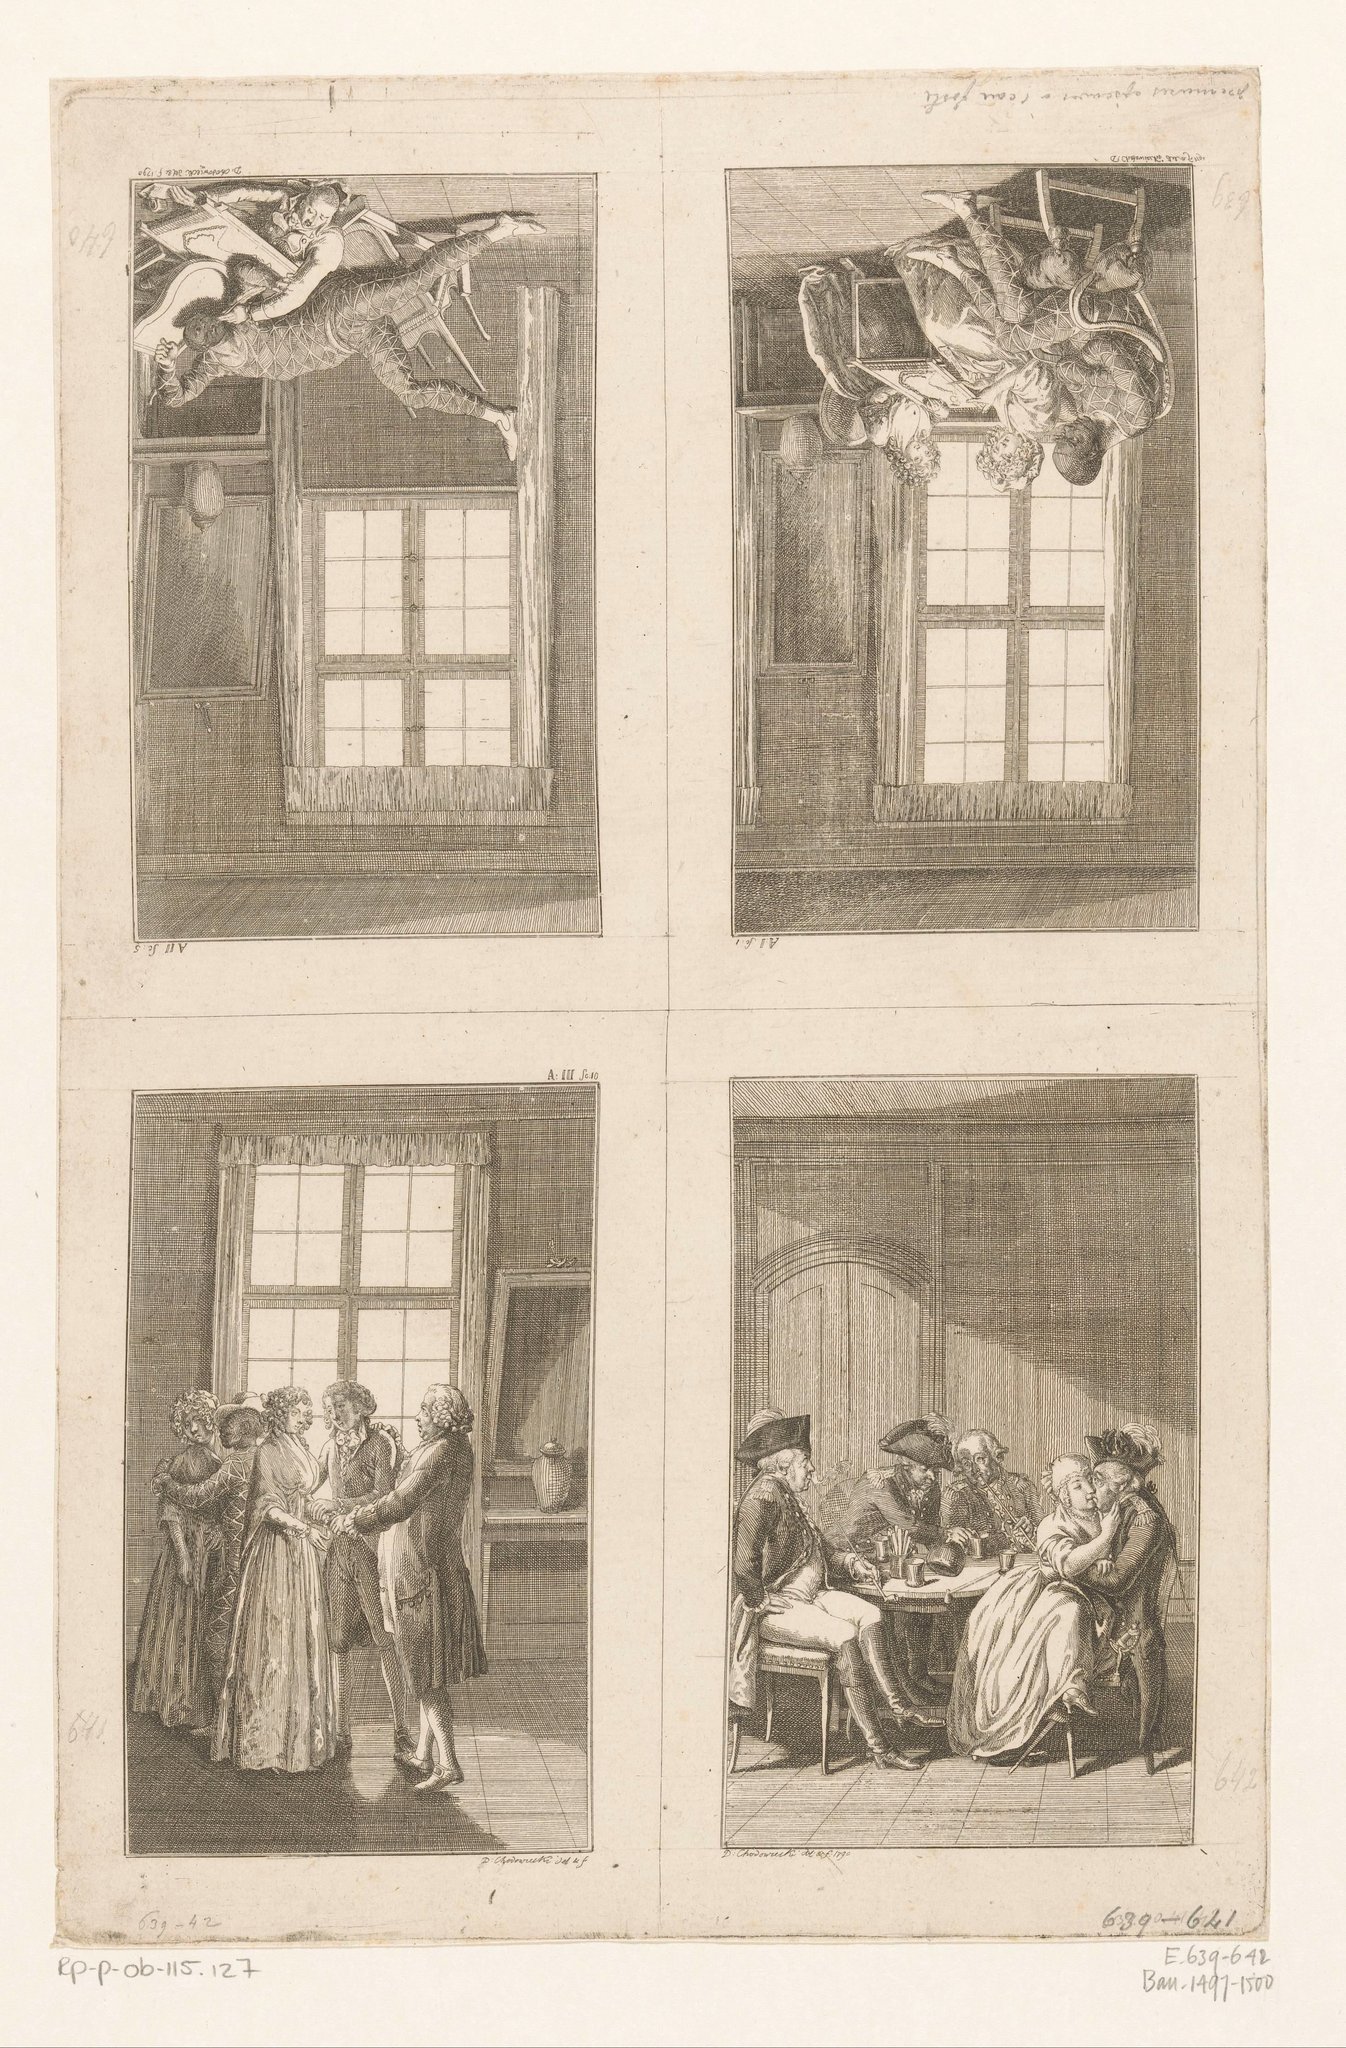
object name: print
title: Vier voorstellingen uit Ewalds Harlekin Patriot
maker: daniel nikolaus chodowiecki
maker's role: draughtsman, print maker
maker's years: 1726-1801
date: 1790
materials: paper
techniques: etching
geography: berlin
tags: literature, (lovers) kissing each other, falling, types in 'commedia dell'arte': harlequin, lovers; courting, flirting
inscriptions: collector's mark: Lugt 2228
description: Prenten gebruikt voor: Ewald, Johannes. Joh. Ewald's samtlige Skrifter. 4 dln. Kopenhagen: s.n., 1781-91.